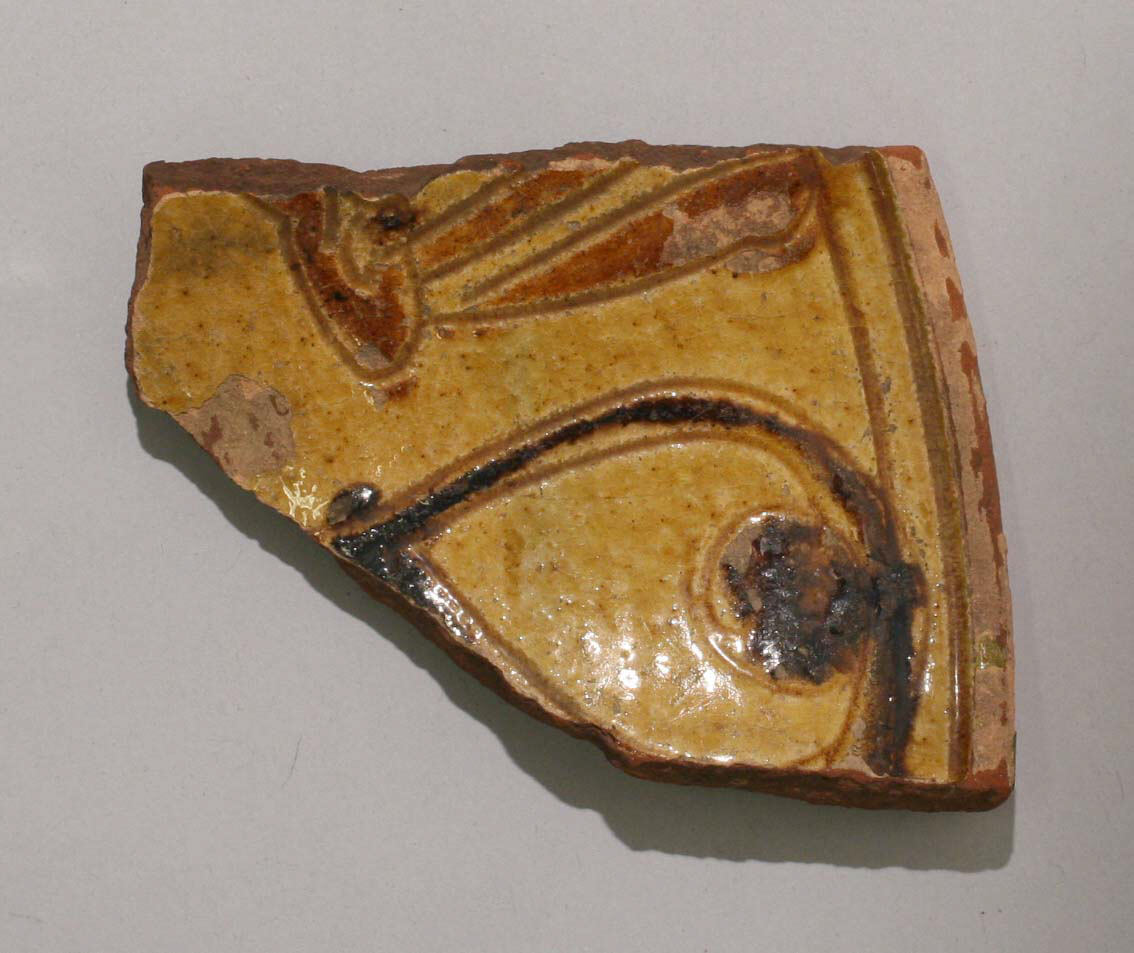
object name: fragment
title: Ceramic Fragment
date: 1301-1500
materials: earthenware, glaze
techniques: coloring, incising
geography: egypt